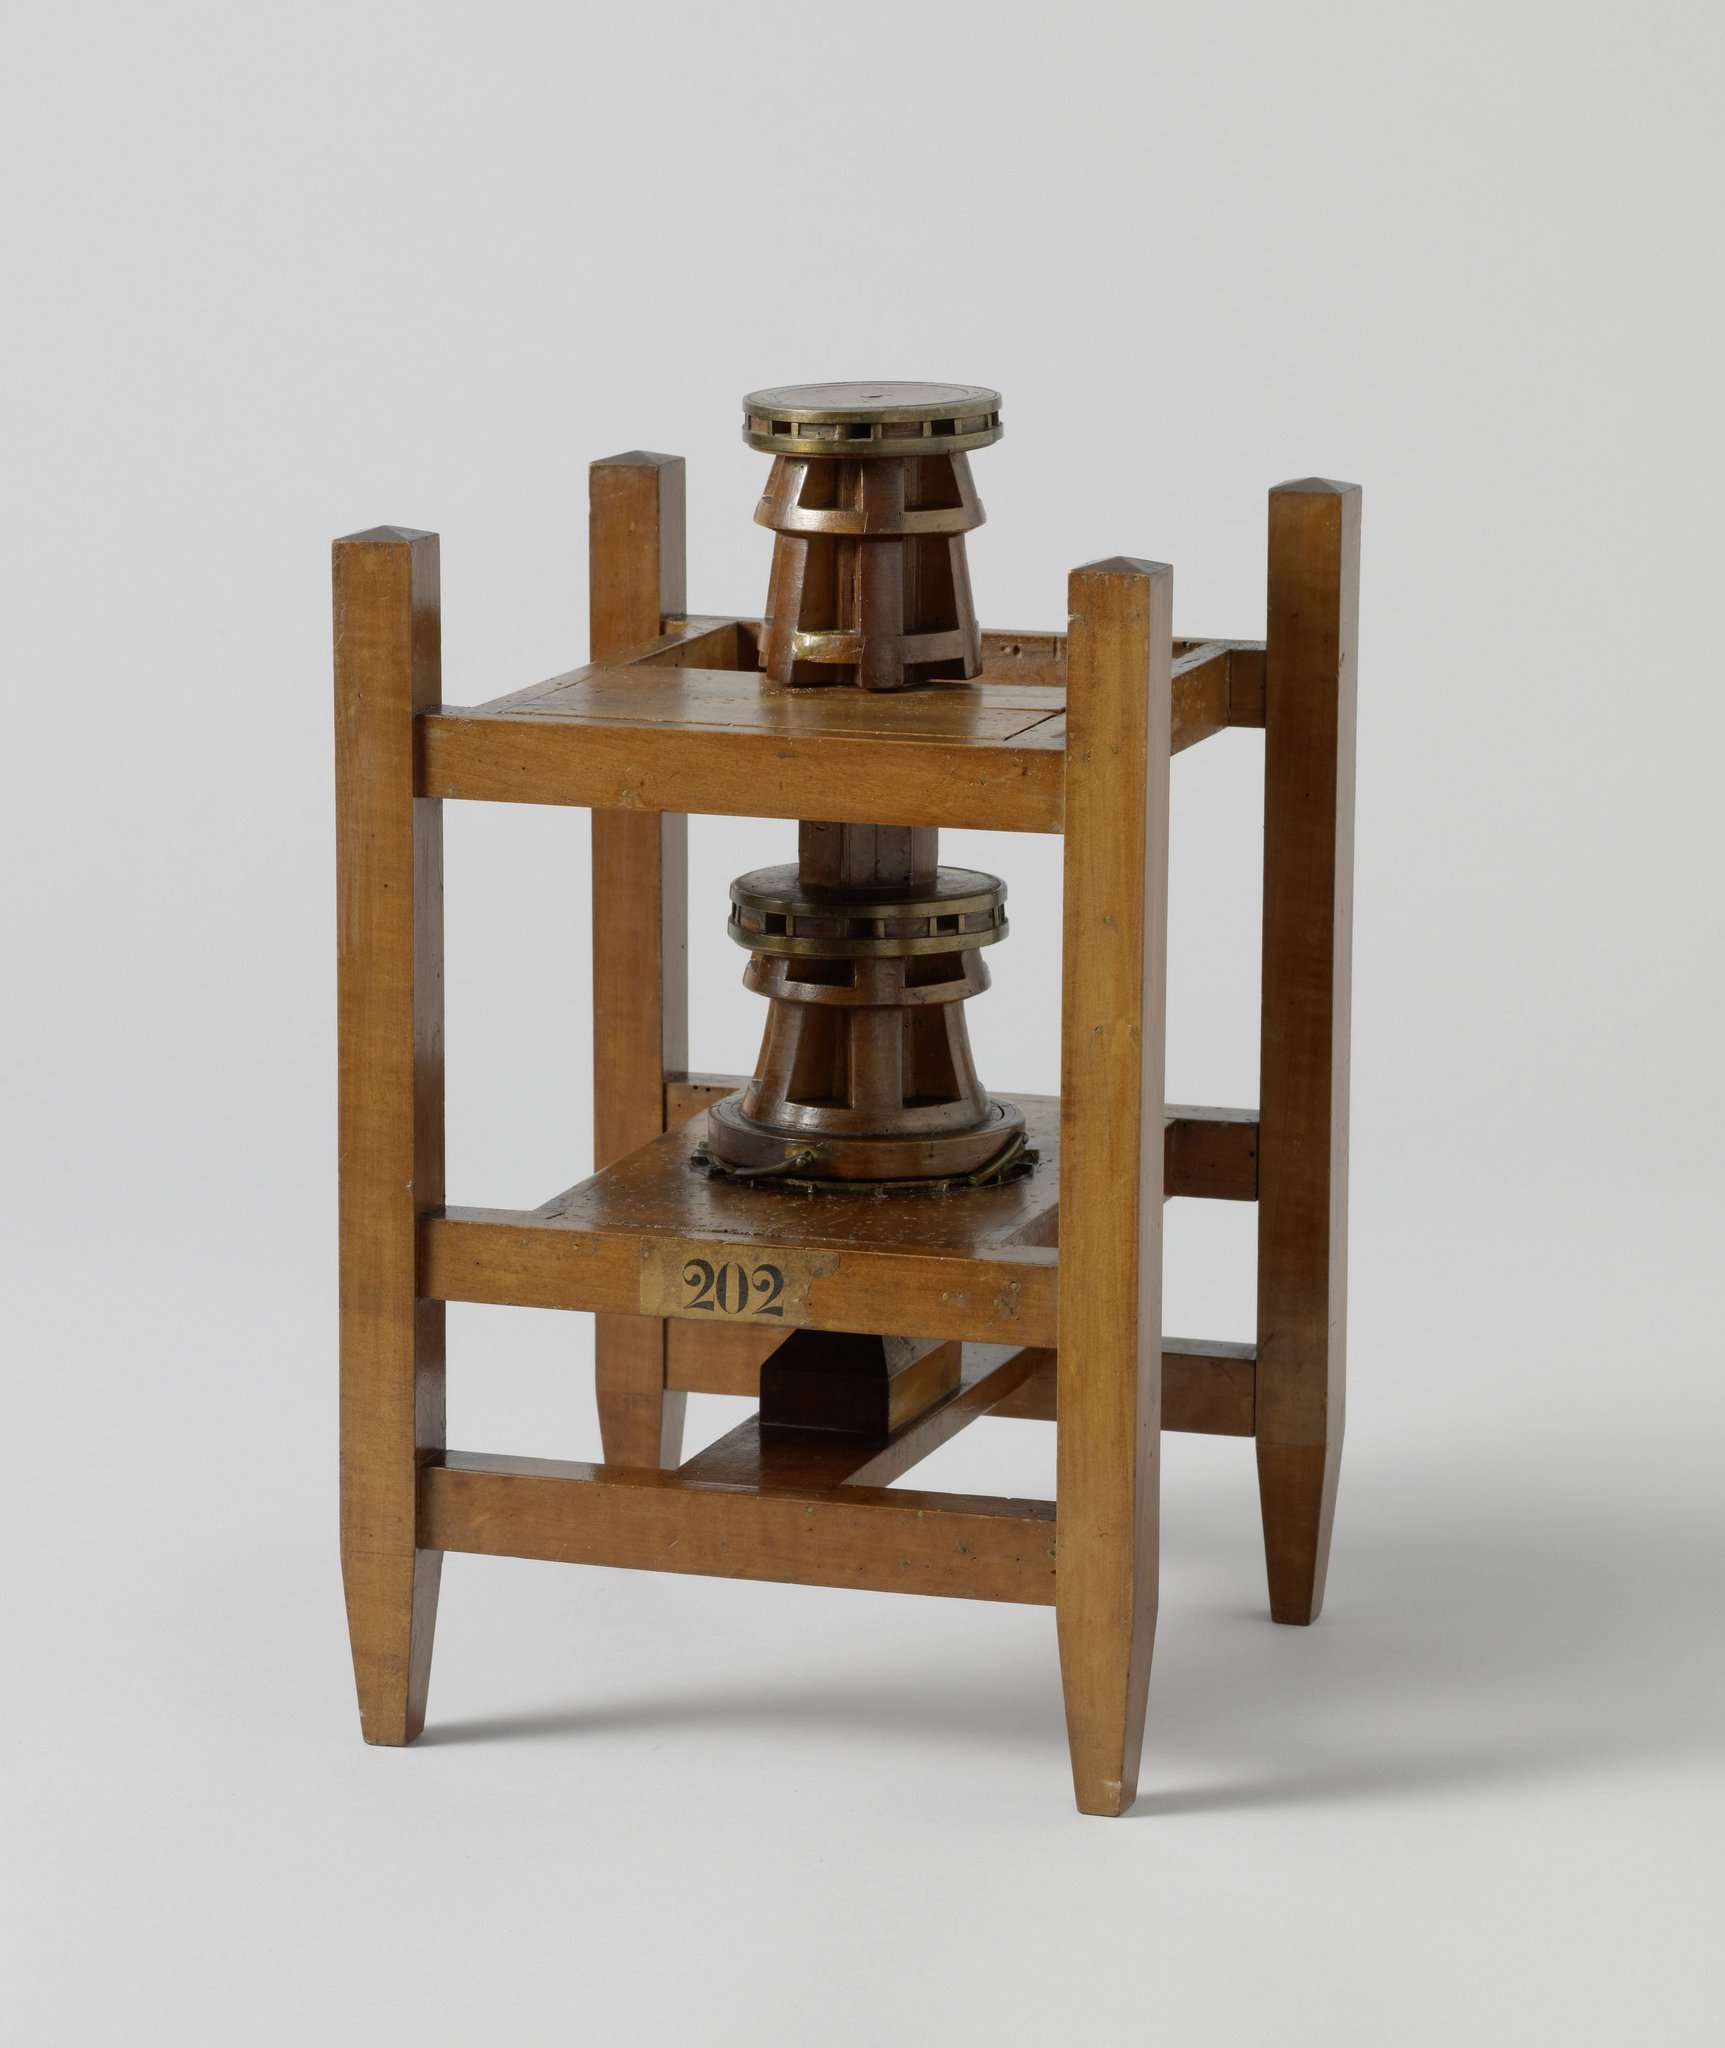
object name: demonstration model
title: Model of a Double Capstan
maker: Anonymous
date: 1800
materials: brass, wood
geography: netherlands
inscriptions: label, on the frame: ‘202’ former inventory label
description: Model van een dubbele kaapstander in een houten frame met drie niveau's. Beide trommels zijn voor negen windbomen, de onderste heeft vier pallen aan de voet tegen het teruglopen. De trommels zijn verbonden met een dikke houten koning, die doorloopt tot het onderste niveau waar hij met een pin in een spoor staat. De trommels hebben ieder zes kiezen in de vorm van een flauwe Z. Schaal 1:20 (schatting).